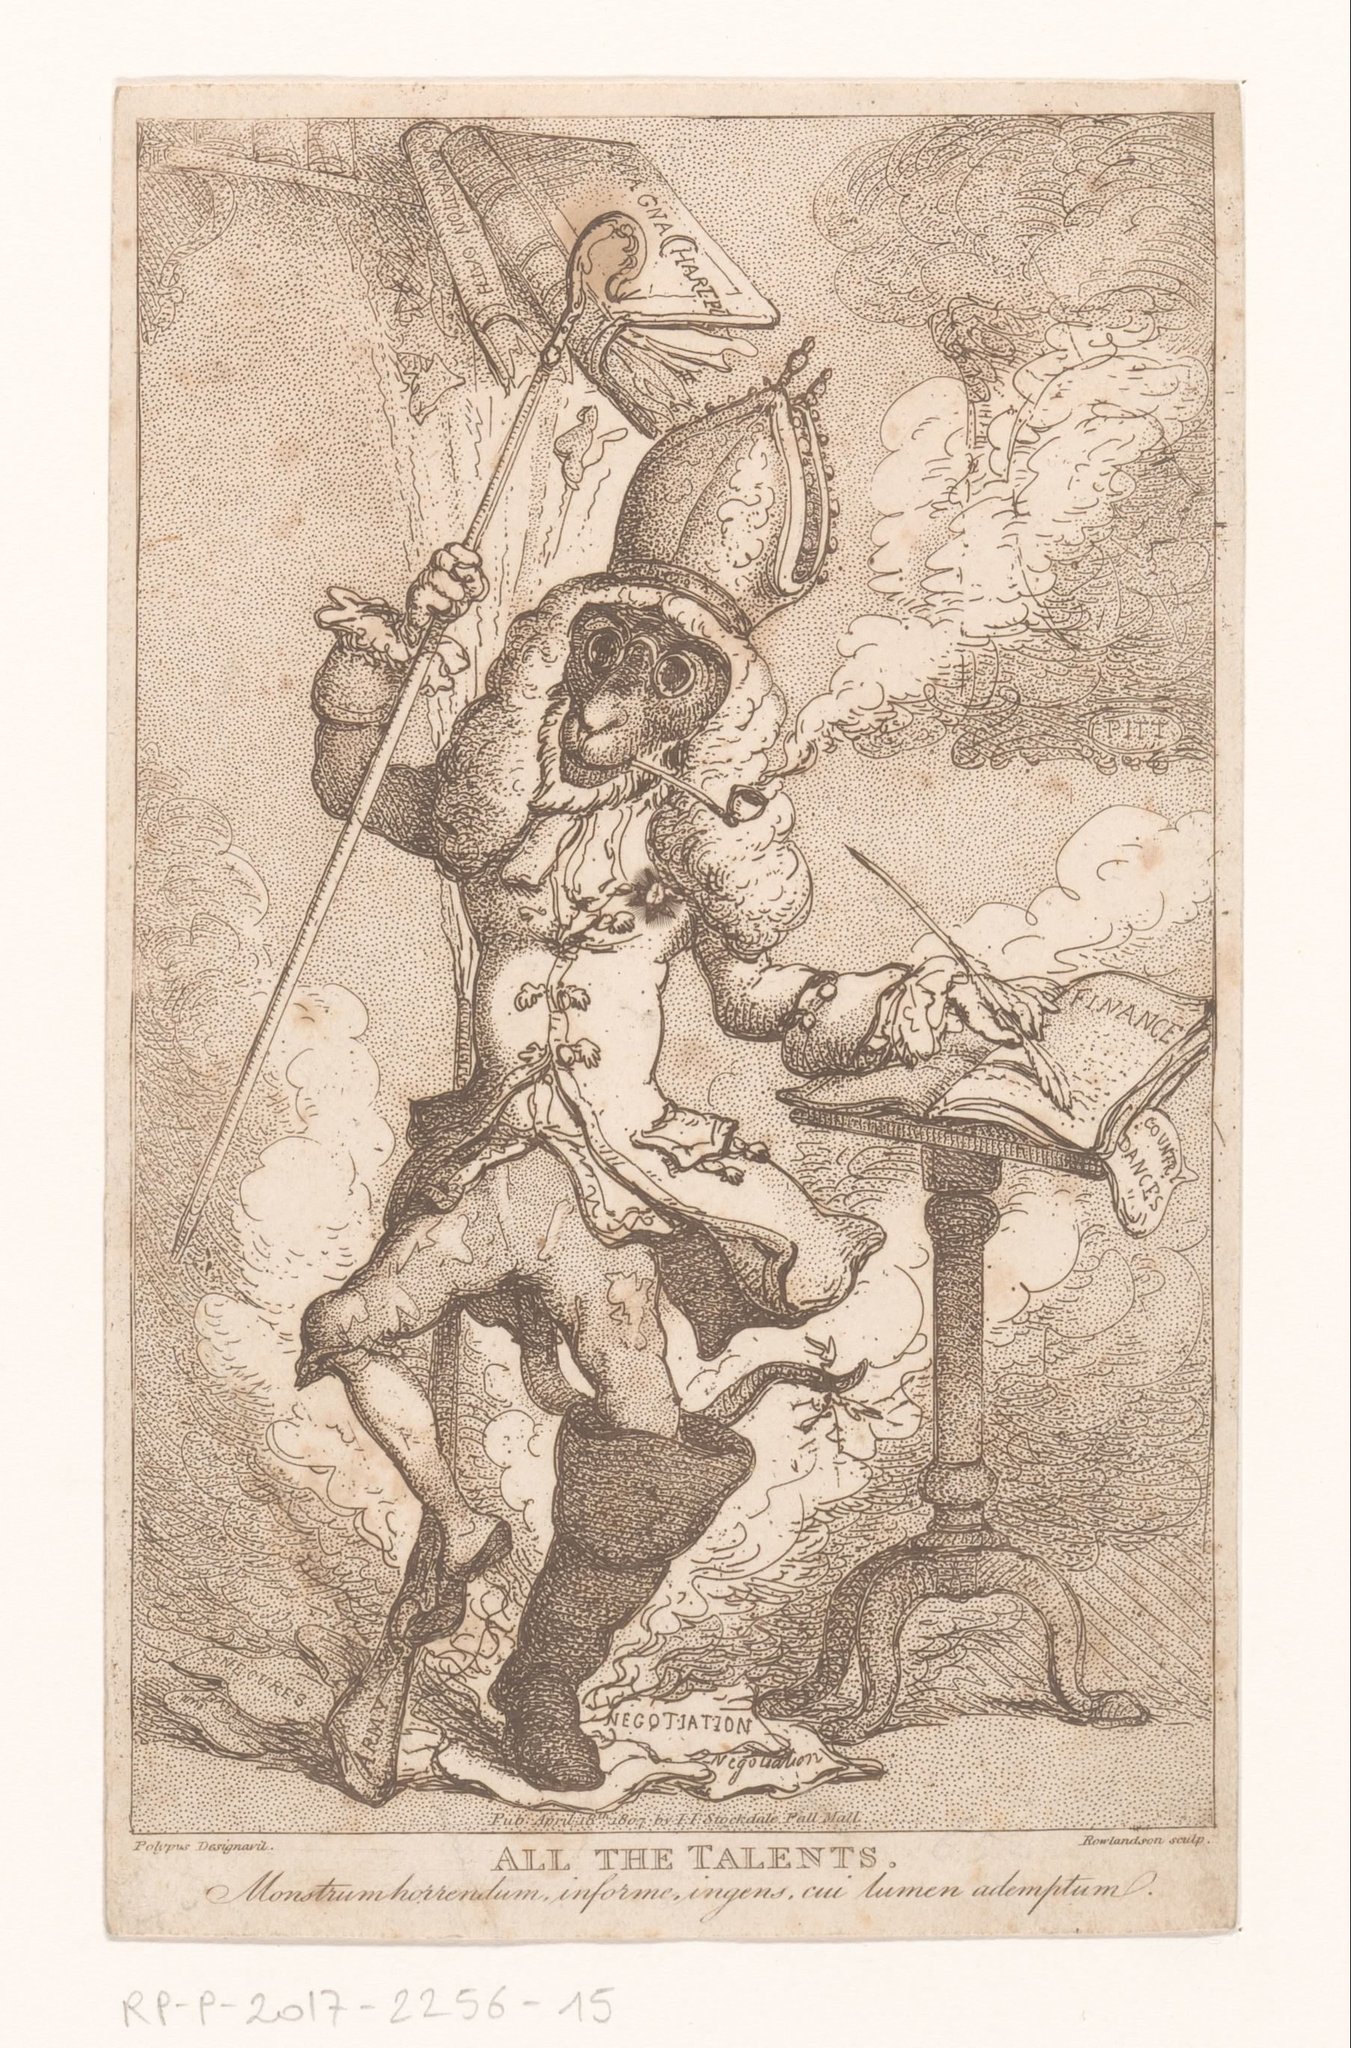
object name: book illustration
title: All the talents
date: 1807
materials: paper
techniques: etching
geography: england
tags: monkeys, apes, politician, e.g. party leader, political caricatures and satires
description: Frontispiece voor 'All the Talents', 18de editie, satirical verses by 'Polypus' (= E. S. Barrett). Spotprent waarin een aap met één hand schrijft in een boek over financiën terwijl met een bischopsstaf in de andere hand boeken van een plank trekt. De aap staat symbool voor de blinde en roekeloze politicus.